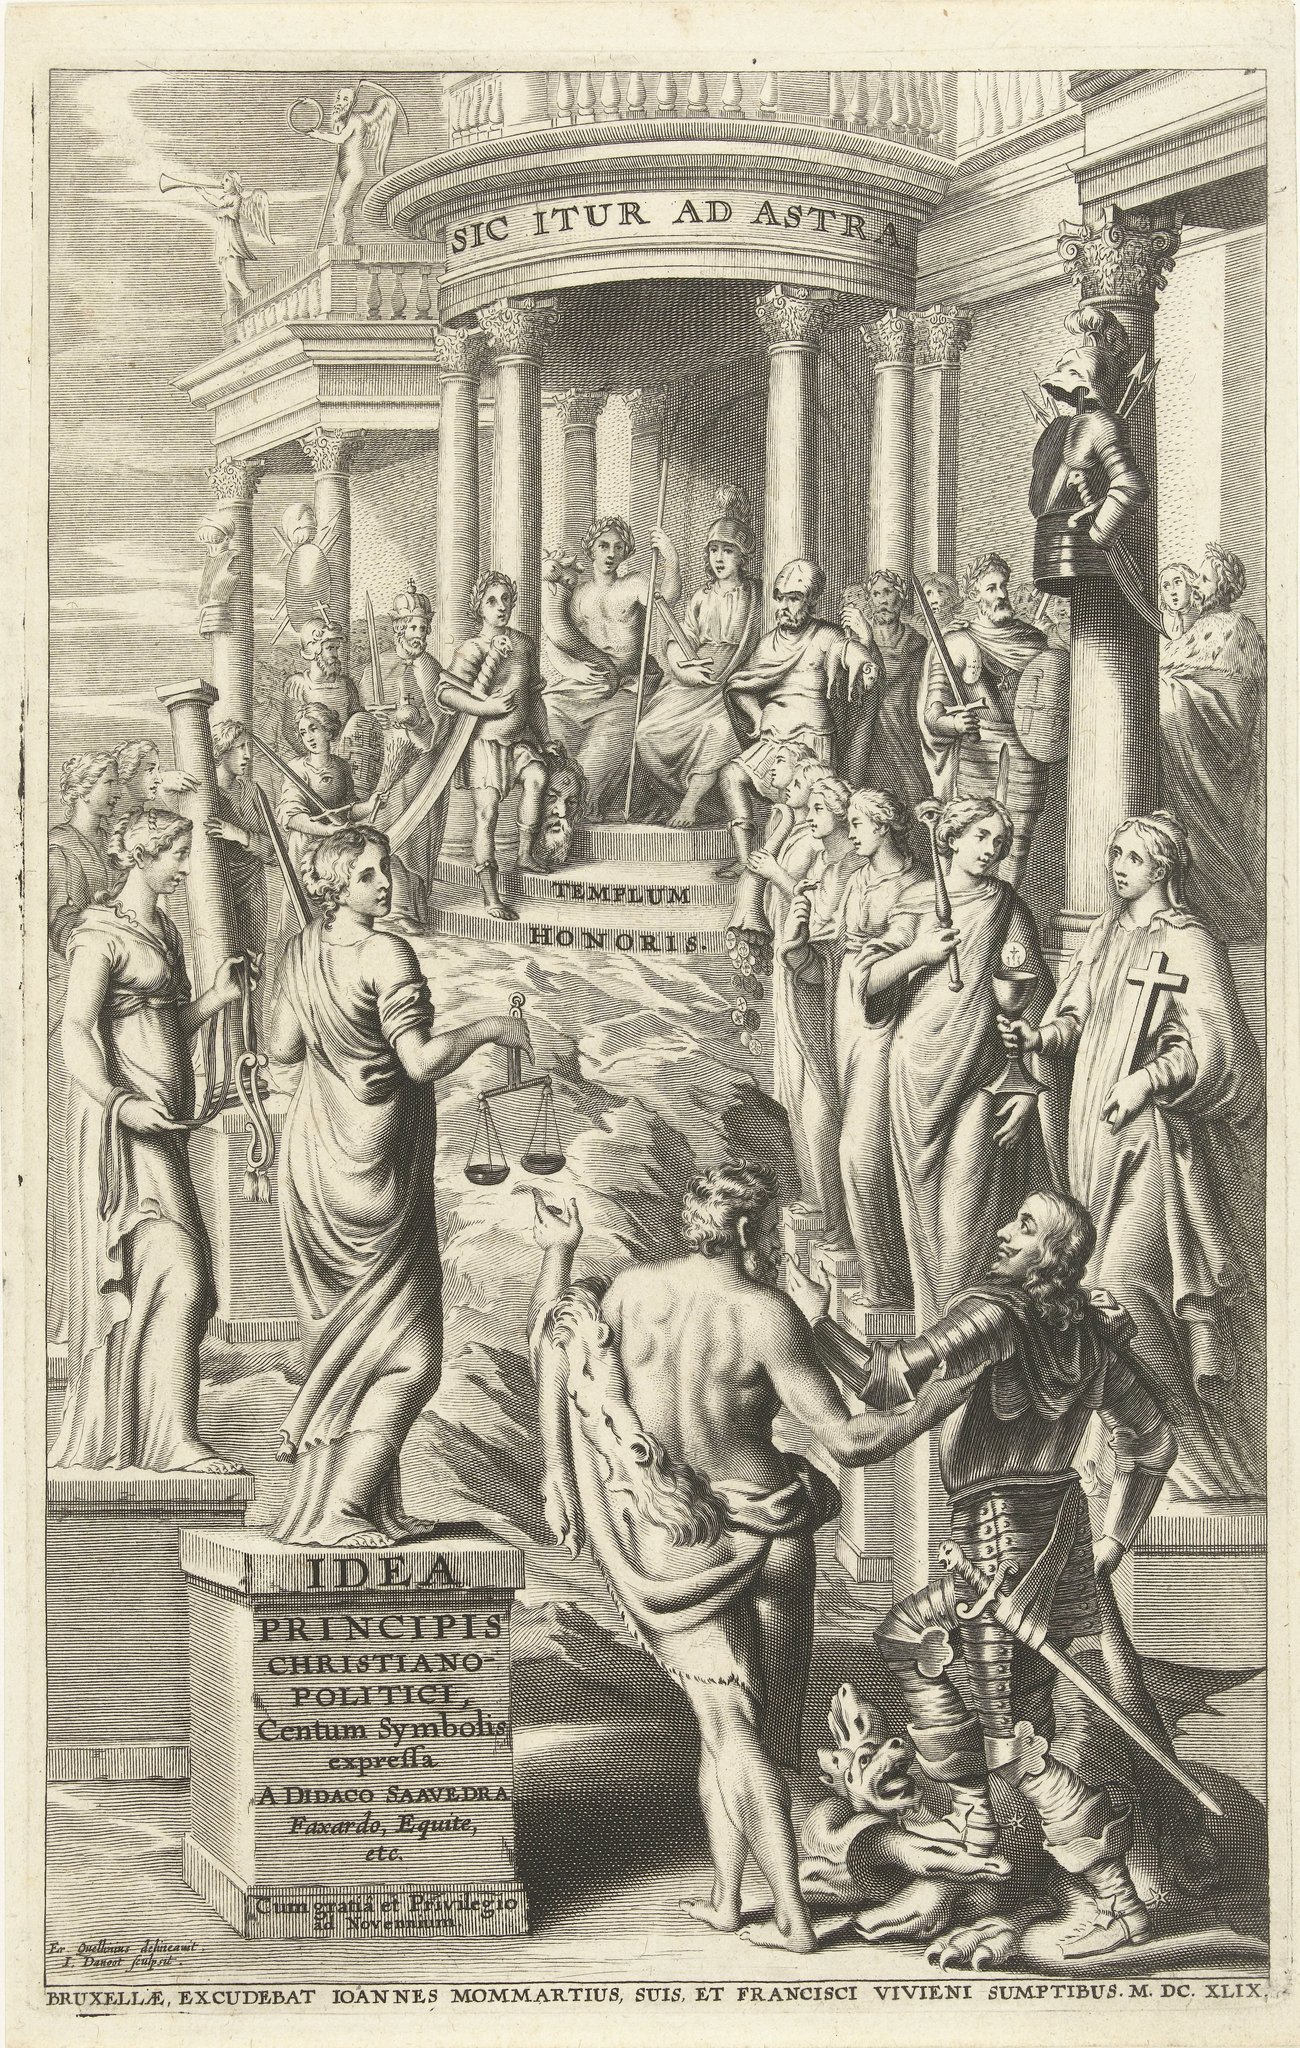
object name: print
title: Hercules leidt man langs personificaties van deugden naar tempel voor eeuwige roem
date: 1649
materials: paper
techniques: engraving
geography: brussels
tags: (story of) hercules (heracles), the seven virtues (symbolized), honour, glory; 'ampiezza della gloria', 'gloria', 'gloria de prencipi', 'gloria & honore', 'honore', 'sublimatà della gloria' (ripa)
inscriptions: collector's mark: Lugt 2228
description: Hercules leidt een man langs personificaties van deugden naar tempel voor eeuwige roem. De man, een heerser, draagt een harnas en vertrapt met zijn voeten een veelkoppige draak, in zijn hand houdt hij een knots. Deugden staan met attributen op sokkels langs een pad dat omhoog leidt naar een tempel waar David met het hoofd van Goliath en andere bijbelse helden wachten en Minerva op een troon zit. Opschrift op het fries van de tempel sic itur ad astra. De symboliek verwijst naar de inhoud van de uitgave waarin de auteur met emblemen aanbevelingen doet voor een heerser, een prins, om met behulp van deugden het juiste politieke leiderschap te tonen.